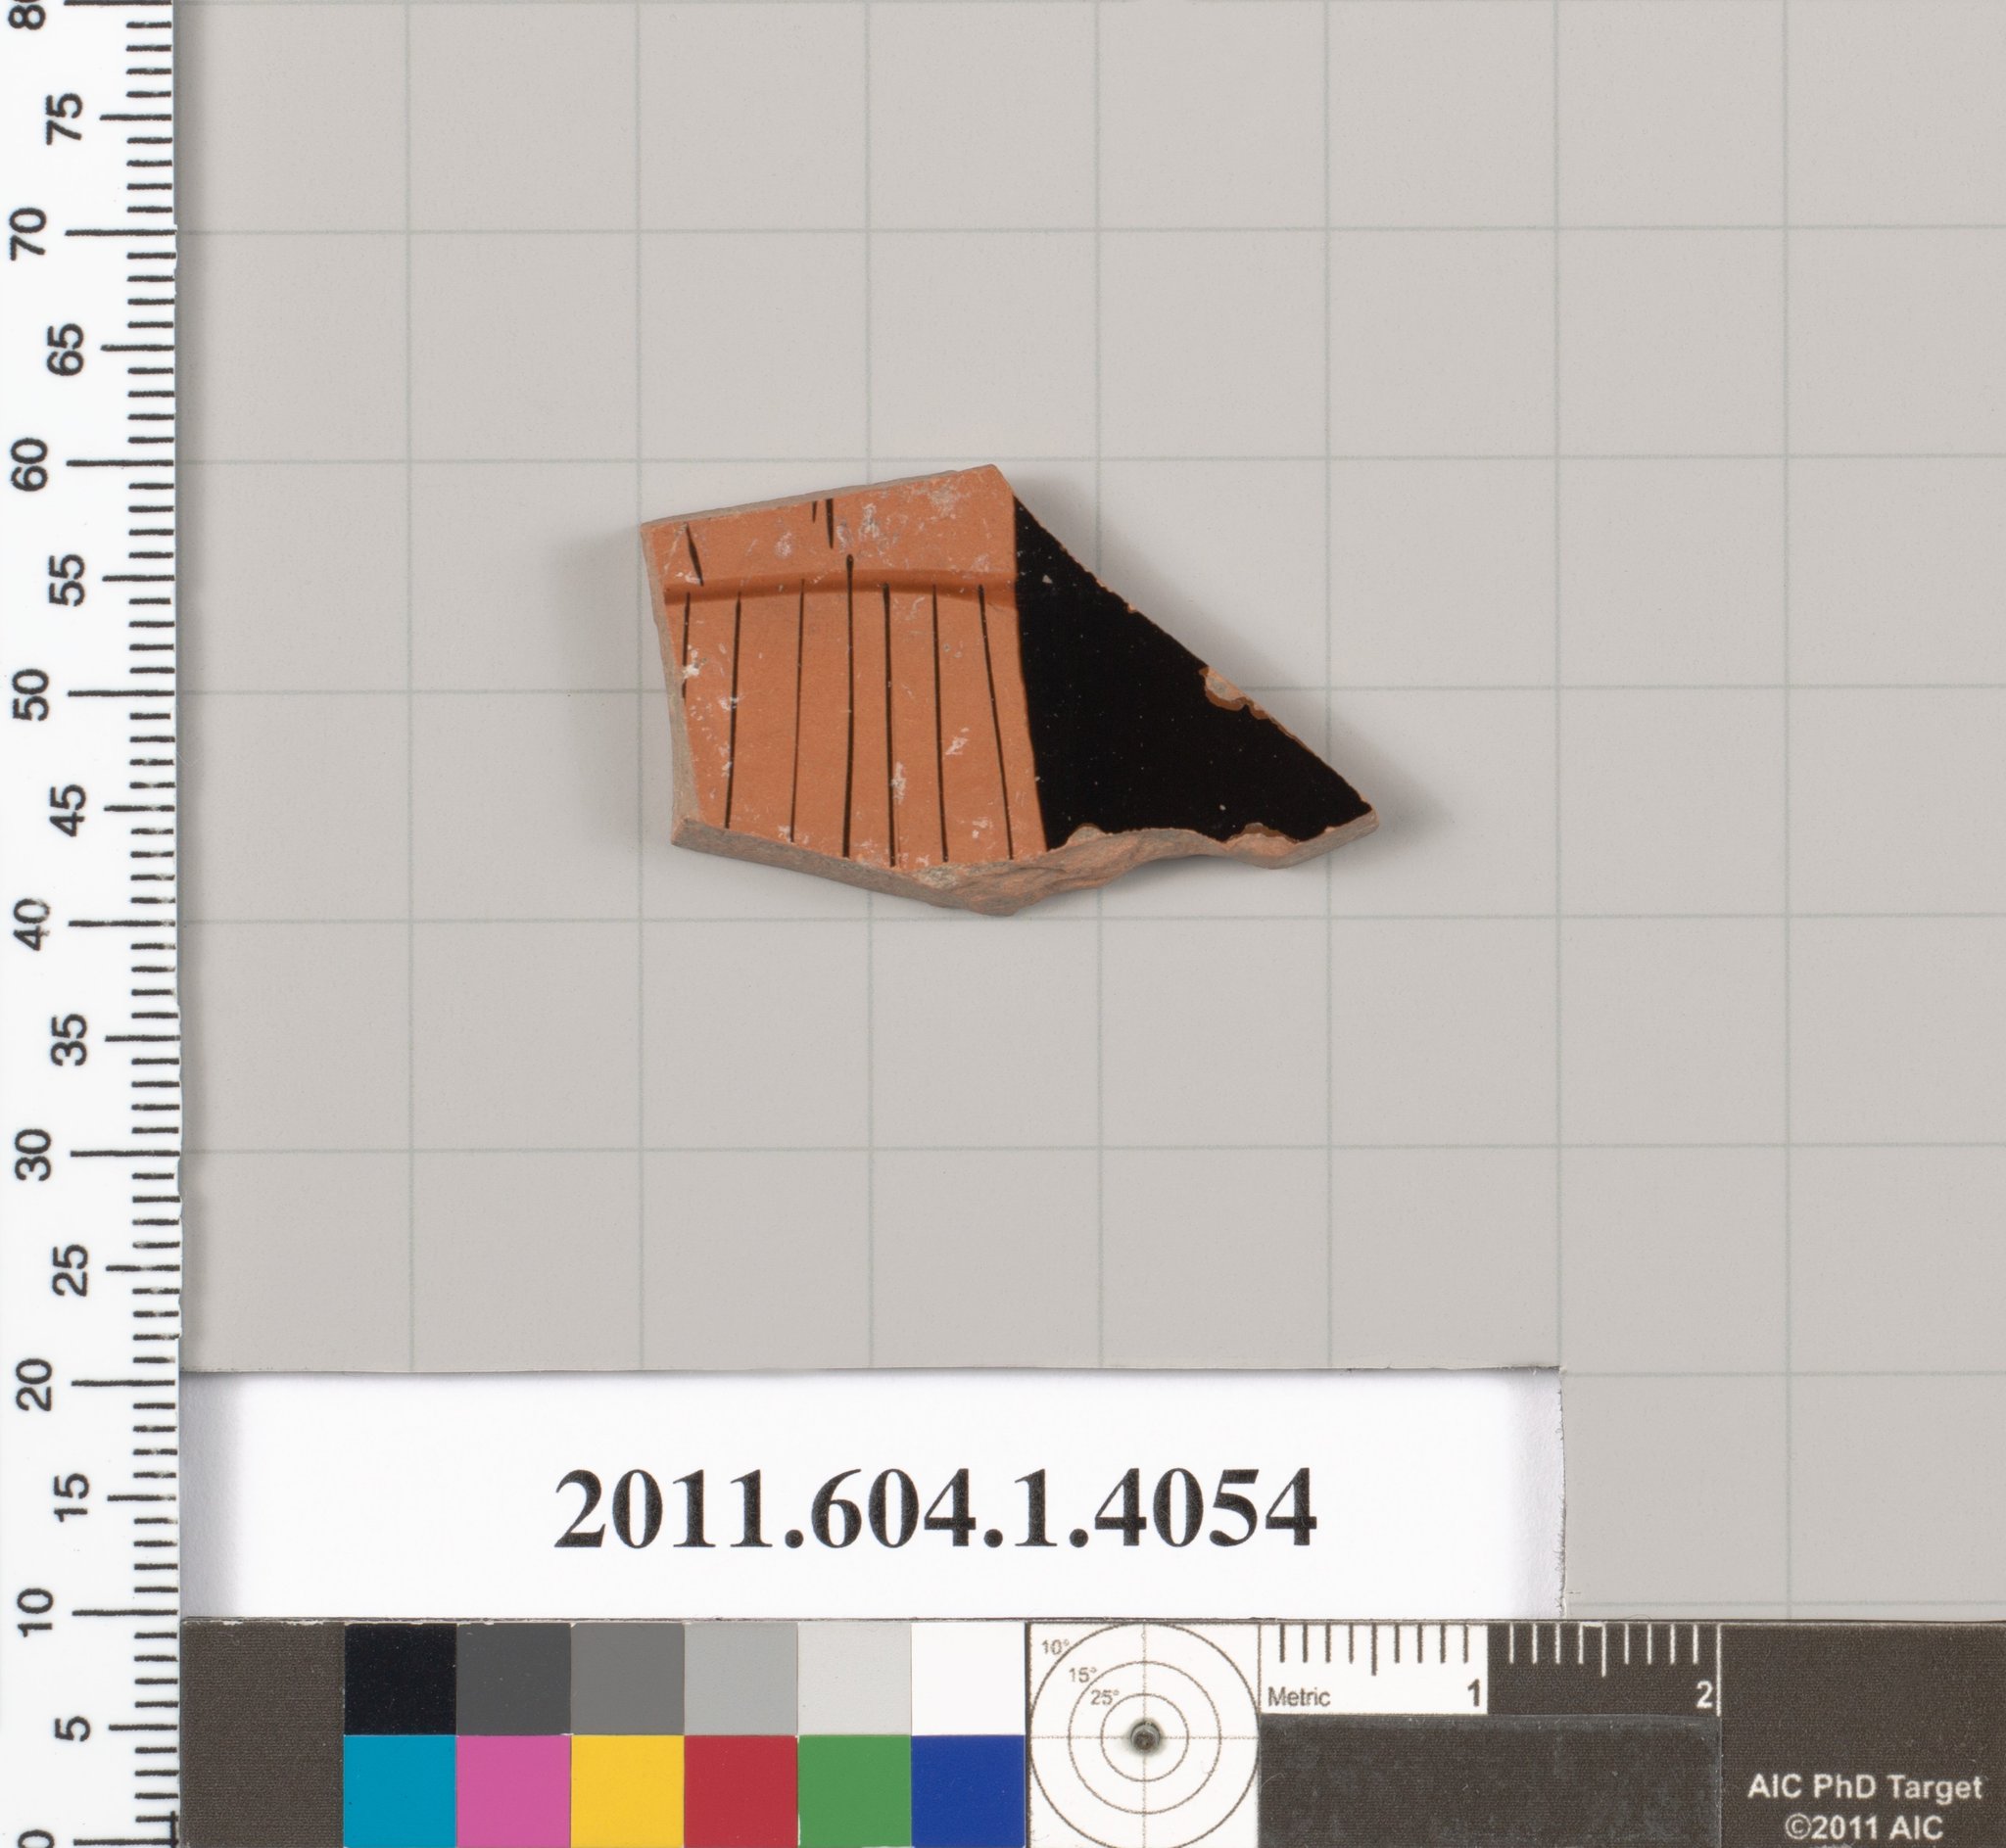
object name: kylix fragment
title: Terracotta fragment of a kylix (drinking cup)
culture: greek, attic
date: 475-451 BCE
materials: terracotta